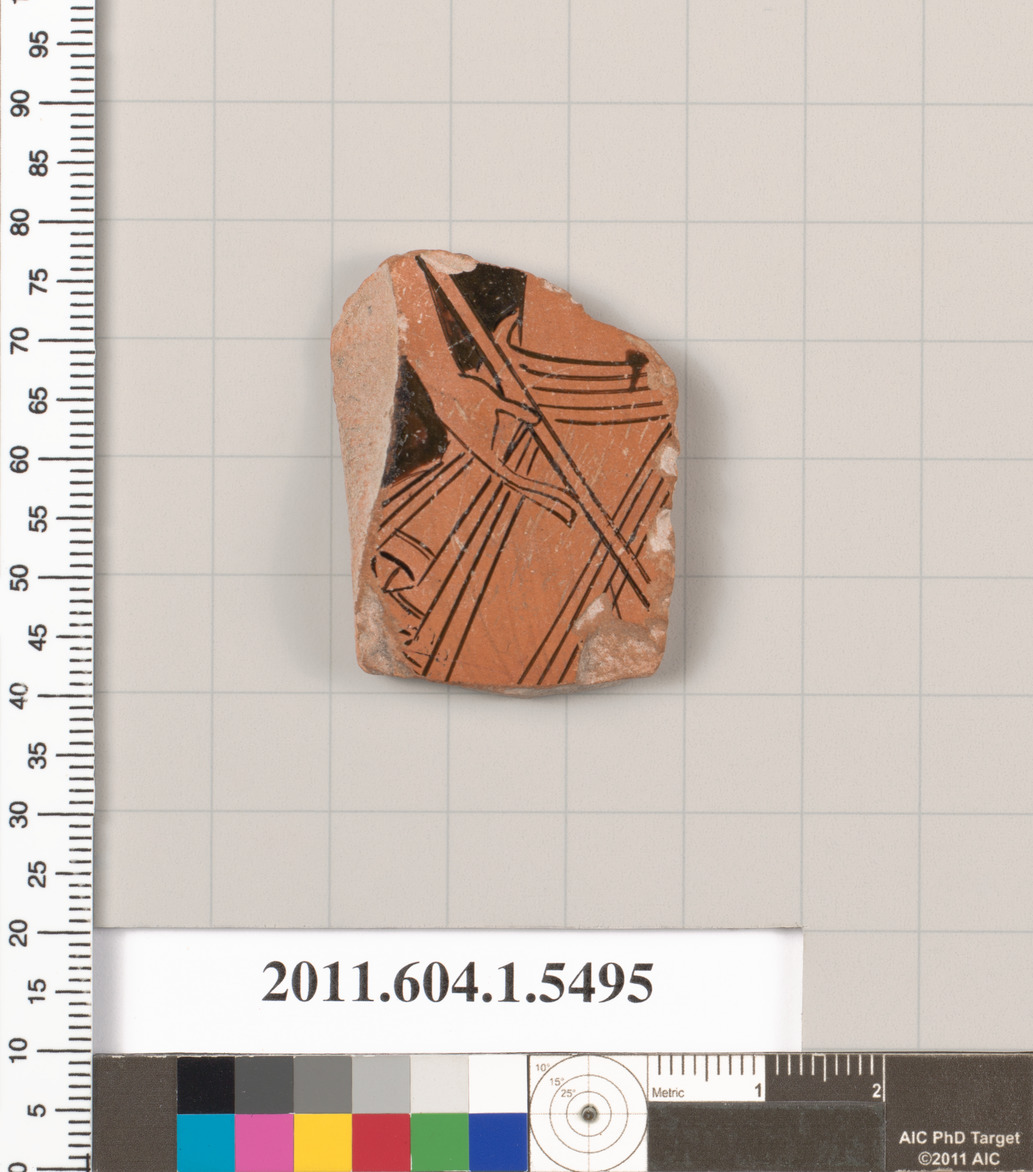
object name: kylix fragment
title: Terracotta fragment of a kylix (drinking cup)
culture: greek, attic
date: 510-490 BCE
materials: terracotta